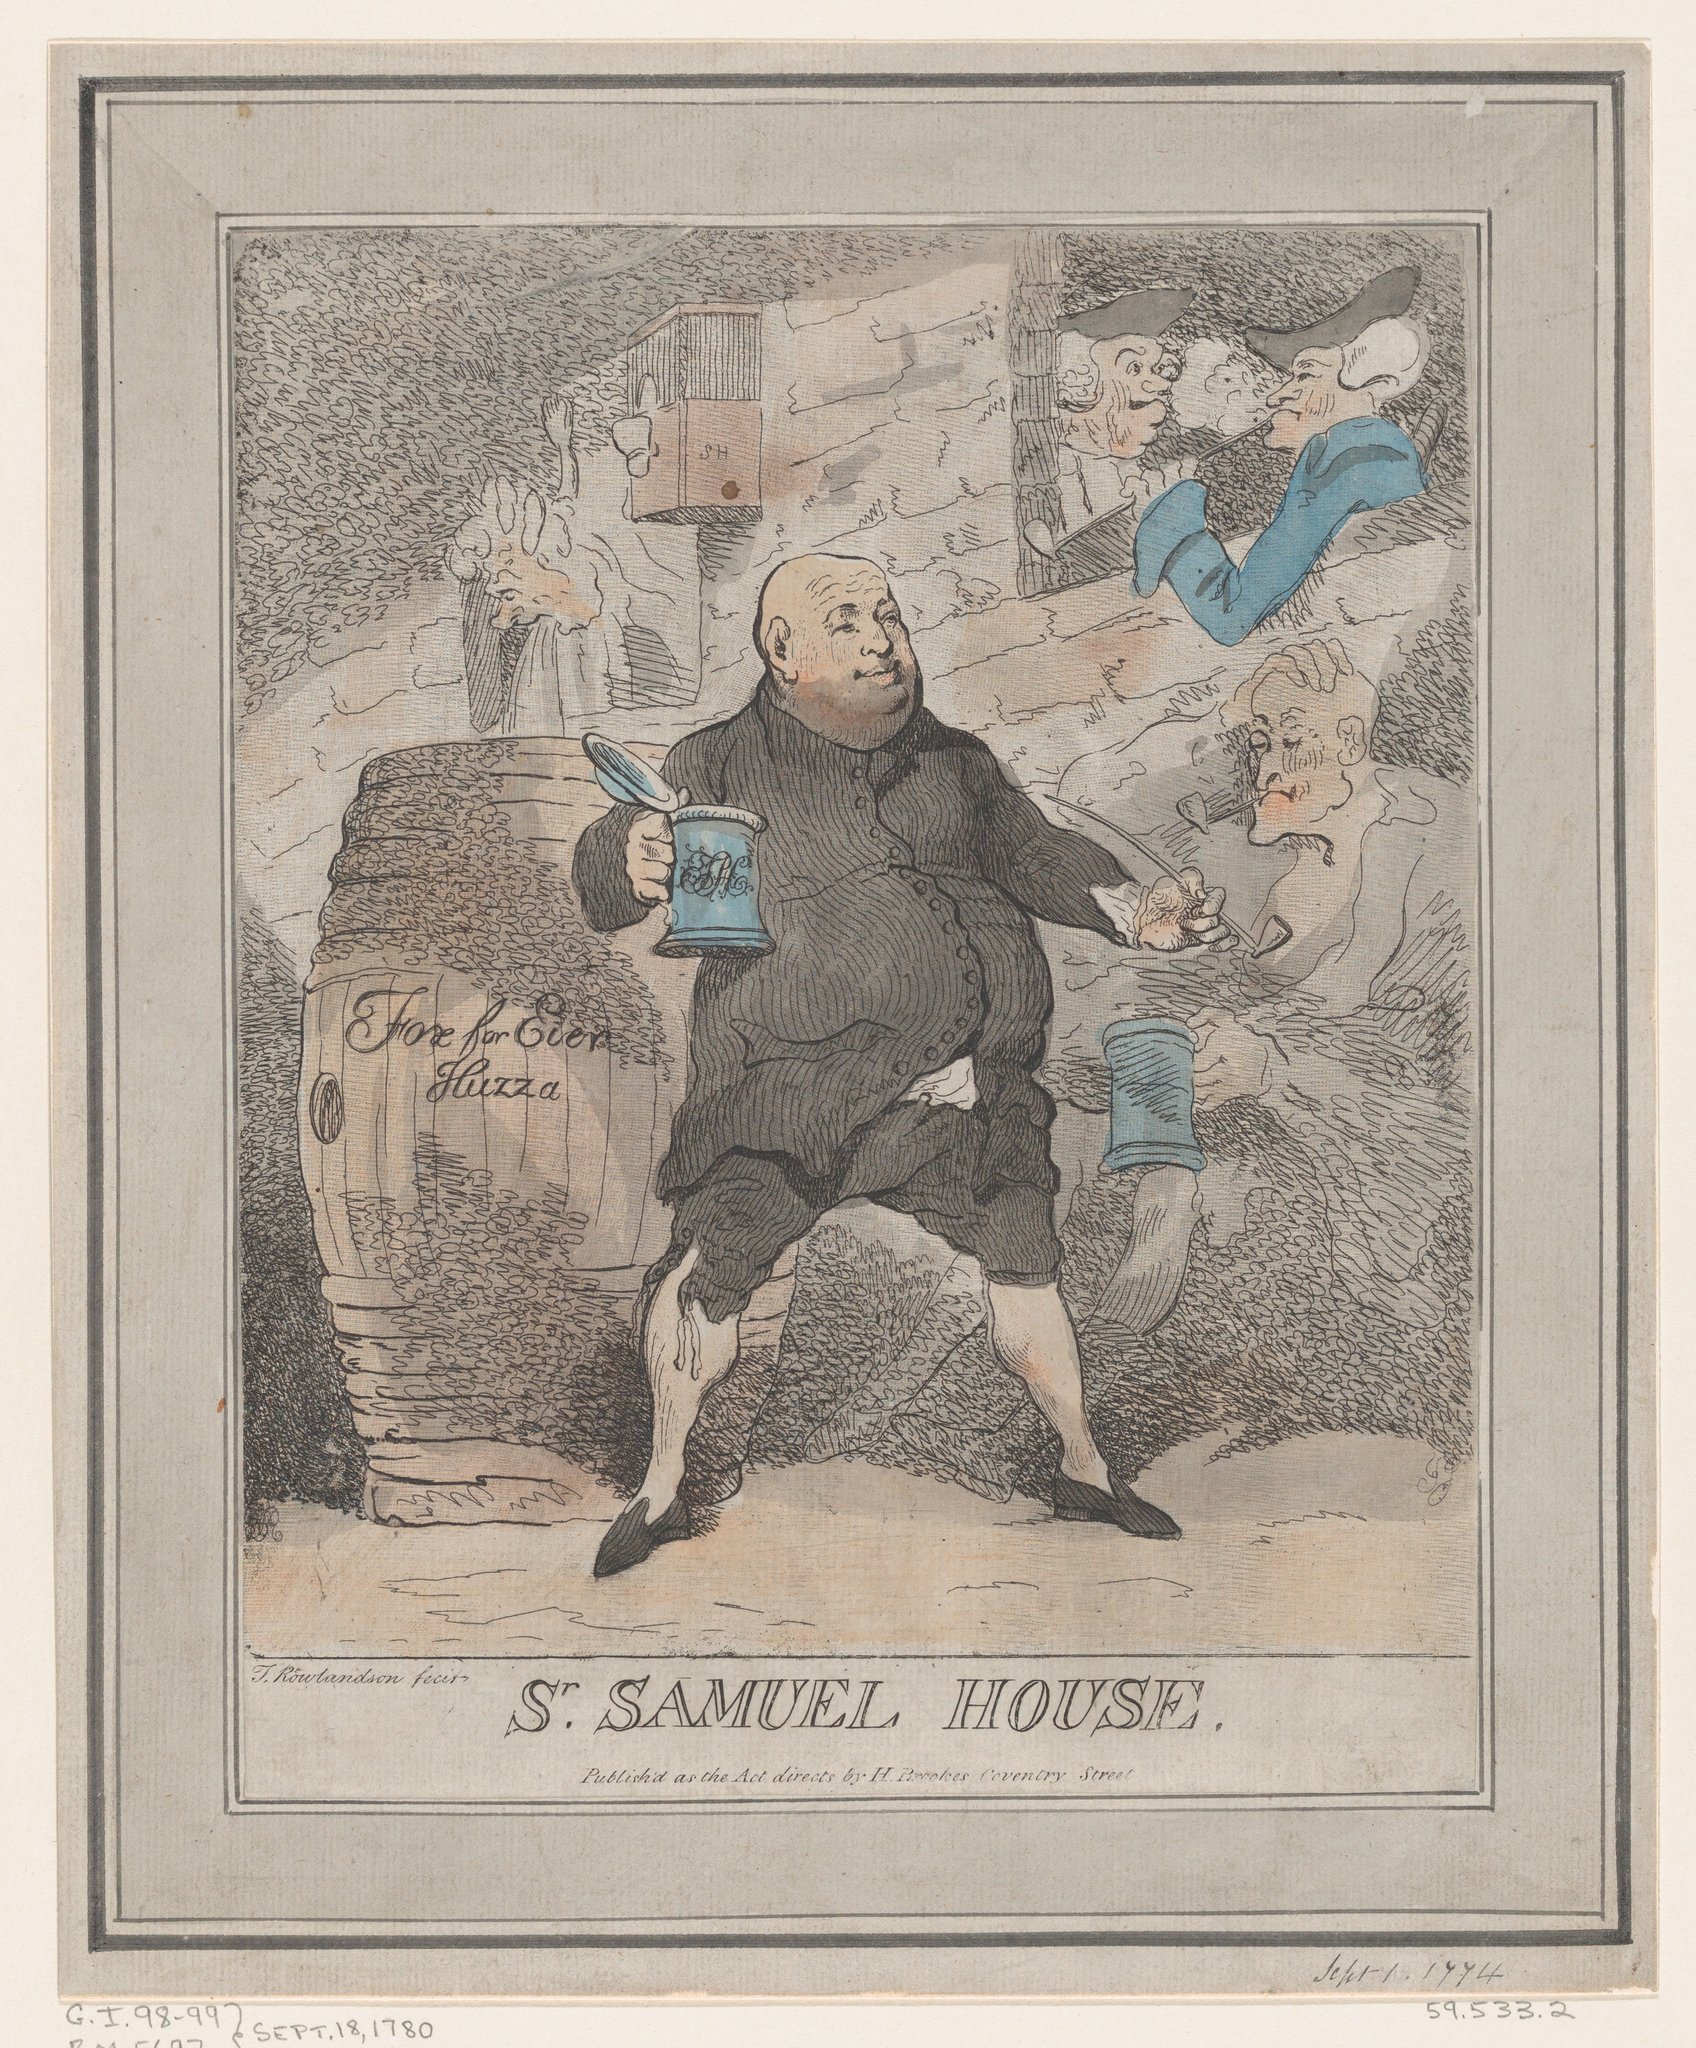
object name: print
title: Sr. Samuel House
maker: thomas rowlandson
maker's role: artist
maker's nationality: british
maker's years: 1757-1827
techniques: etching, roulette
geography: london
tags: satire,men,smoking,drinking,politics